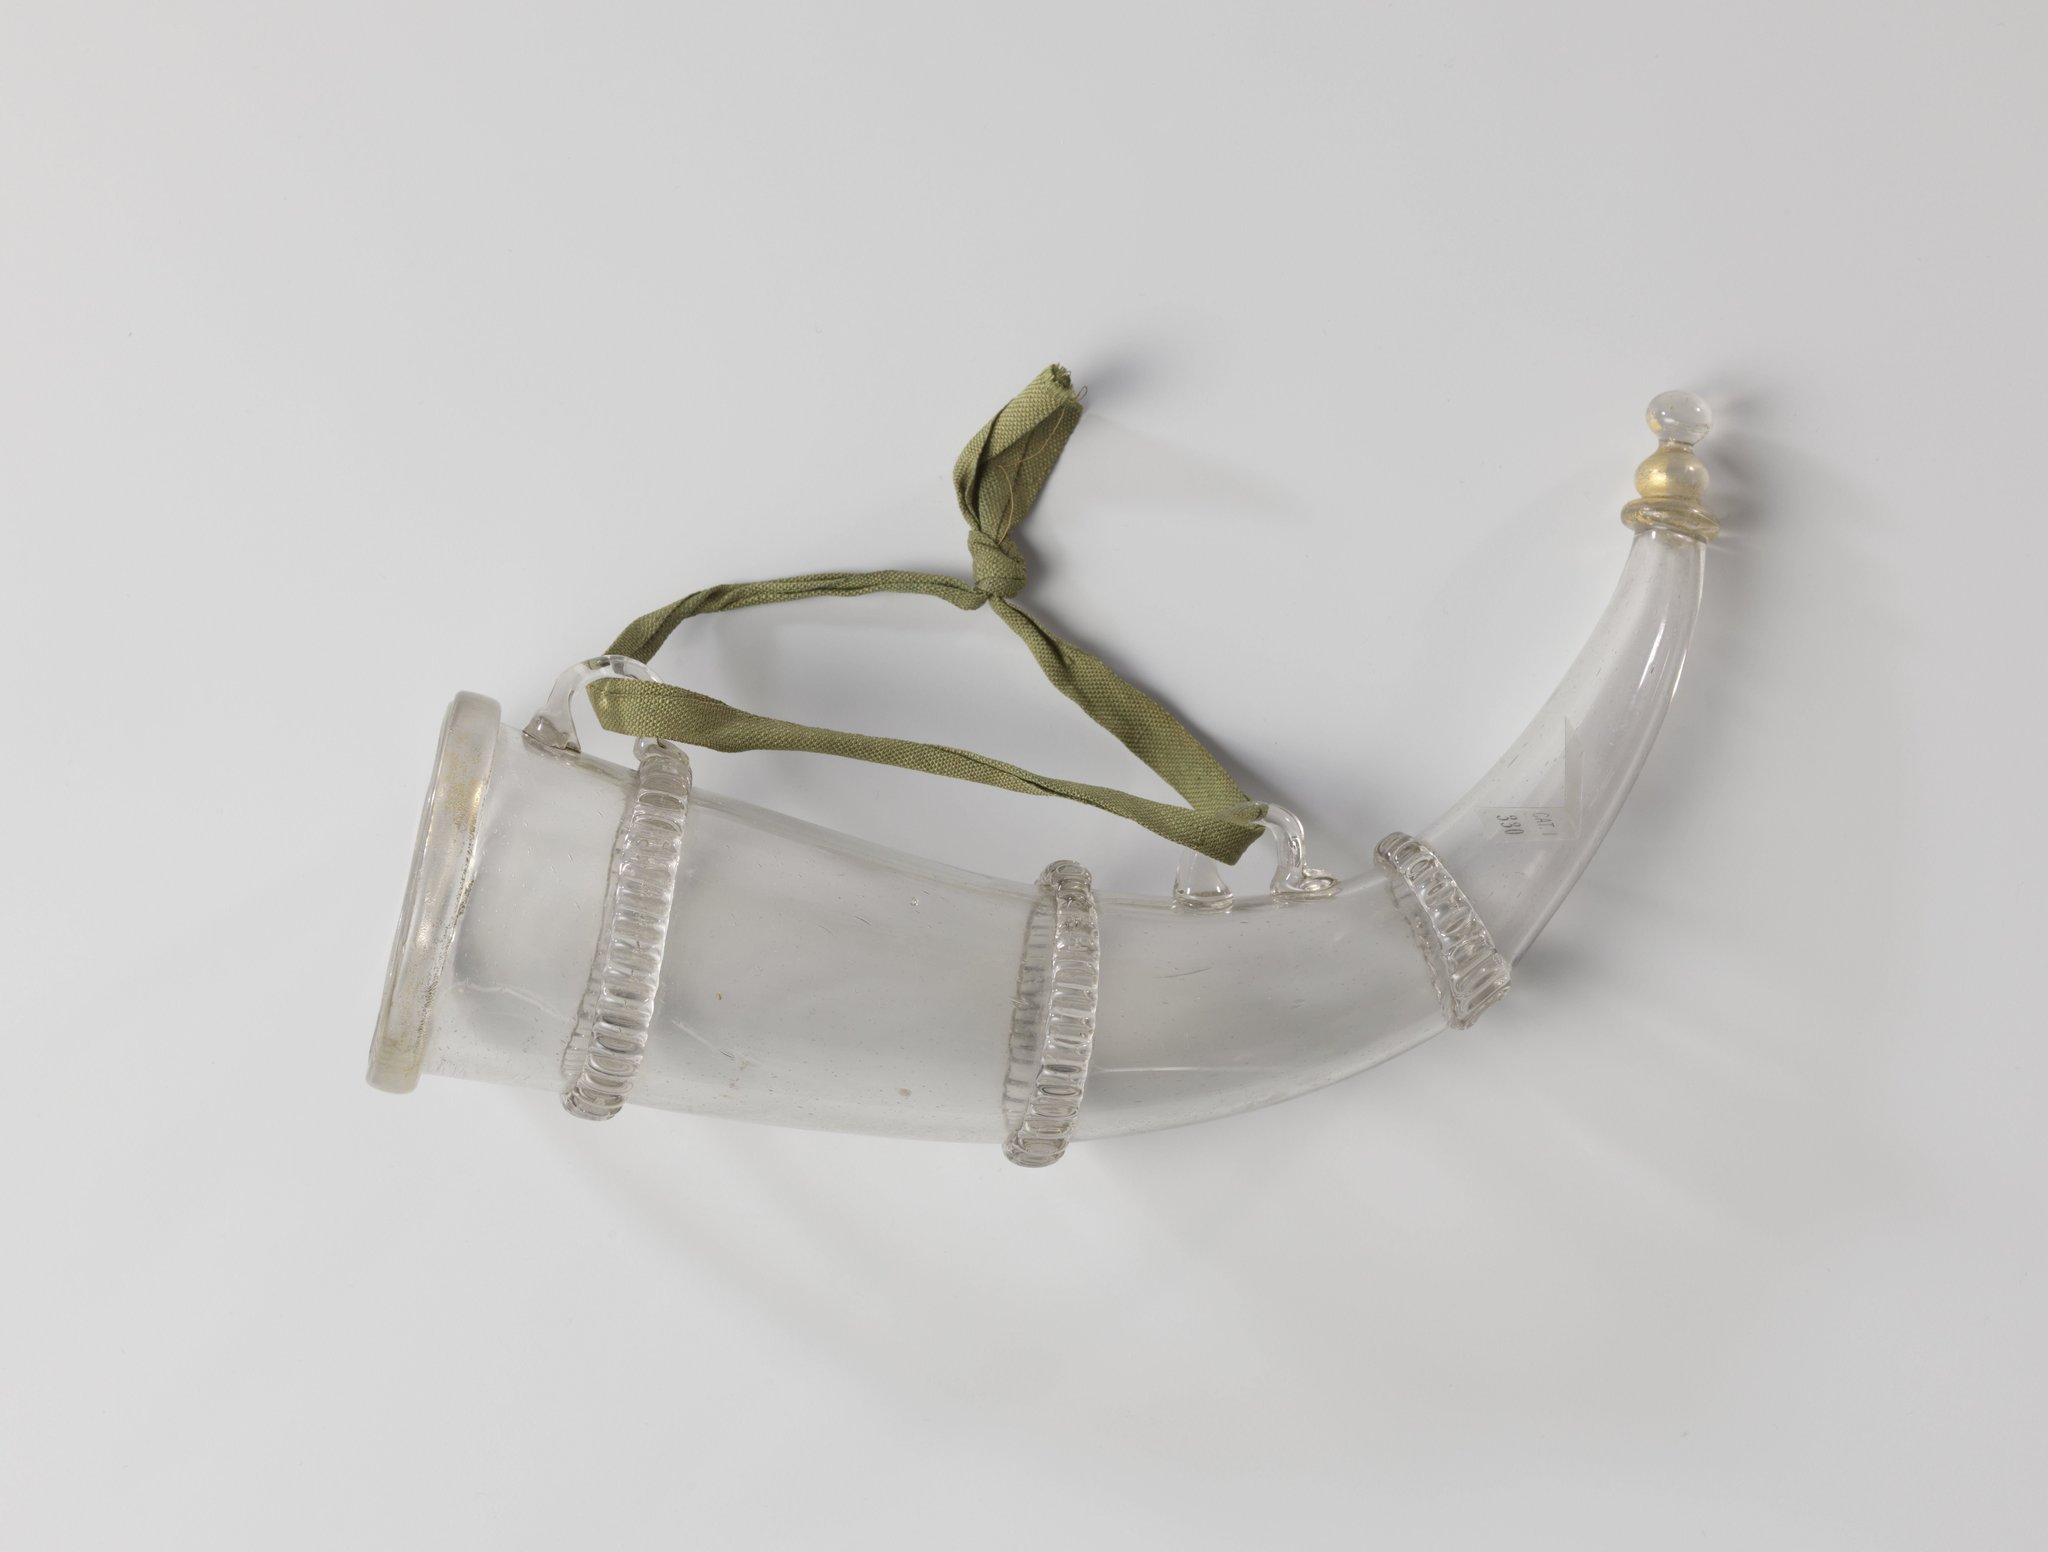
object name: drinking horn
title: Drinkhoorn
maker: Anonymous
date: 1590-1700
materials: glass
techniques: façon de venise, gilding, glassblowing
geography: low countries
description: Gladde, gebogen, zich verwijdende buis, de brede zijde afgezet met een glasdraad, de smalle zijde eindigend in een ring en een dubbele knop. Op het lichaam drie geribde glasdraden en twee gladde ogen.Langs de bovenrand en op de knop resten van verguldsel.